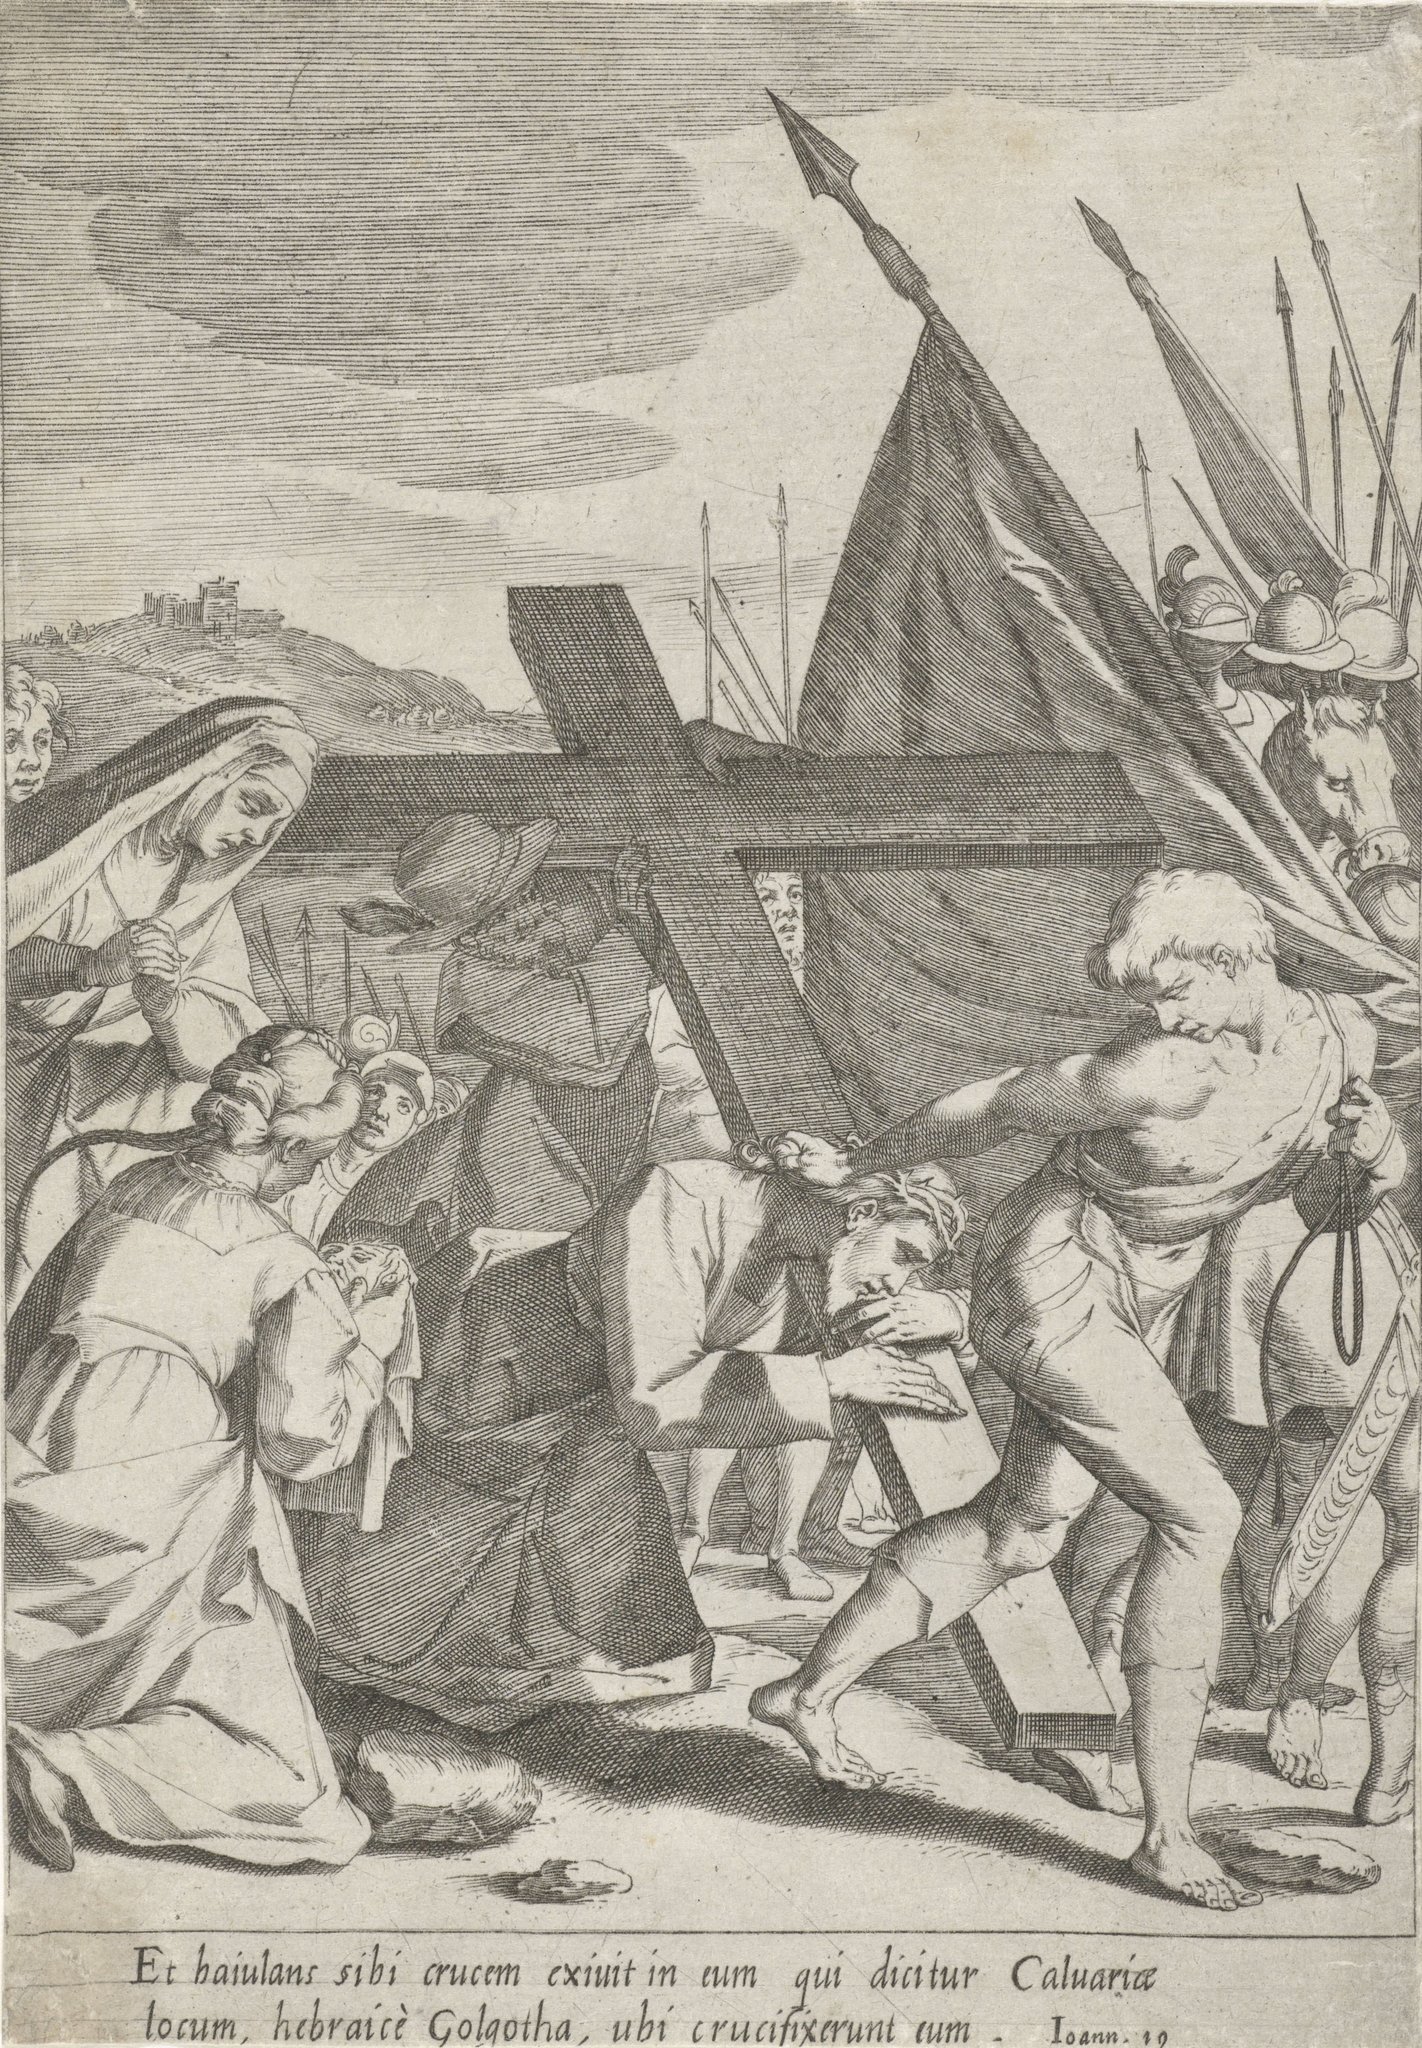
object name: print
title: Passionis et resurrectionis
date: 1590-1632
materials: paper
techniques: engraving, etching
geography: italy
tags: christ collapsing ~ carrying of the cross, christ meets veronica, who has a cloth to wipe christ's face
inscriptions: collector's mark: Lugt 2228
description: Christus valt tijdens het dragen van zijn kruis naar Golgota. Simon van Cyrene helpt hem. Links op de voorgrond biedt Veronica een doek aan om zijn zweet af te drogen. In de marge een tweeregelig onderschrift in het Latijn. Prent uit een serie van vijftien met de passie van Christus.